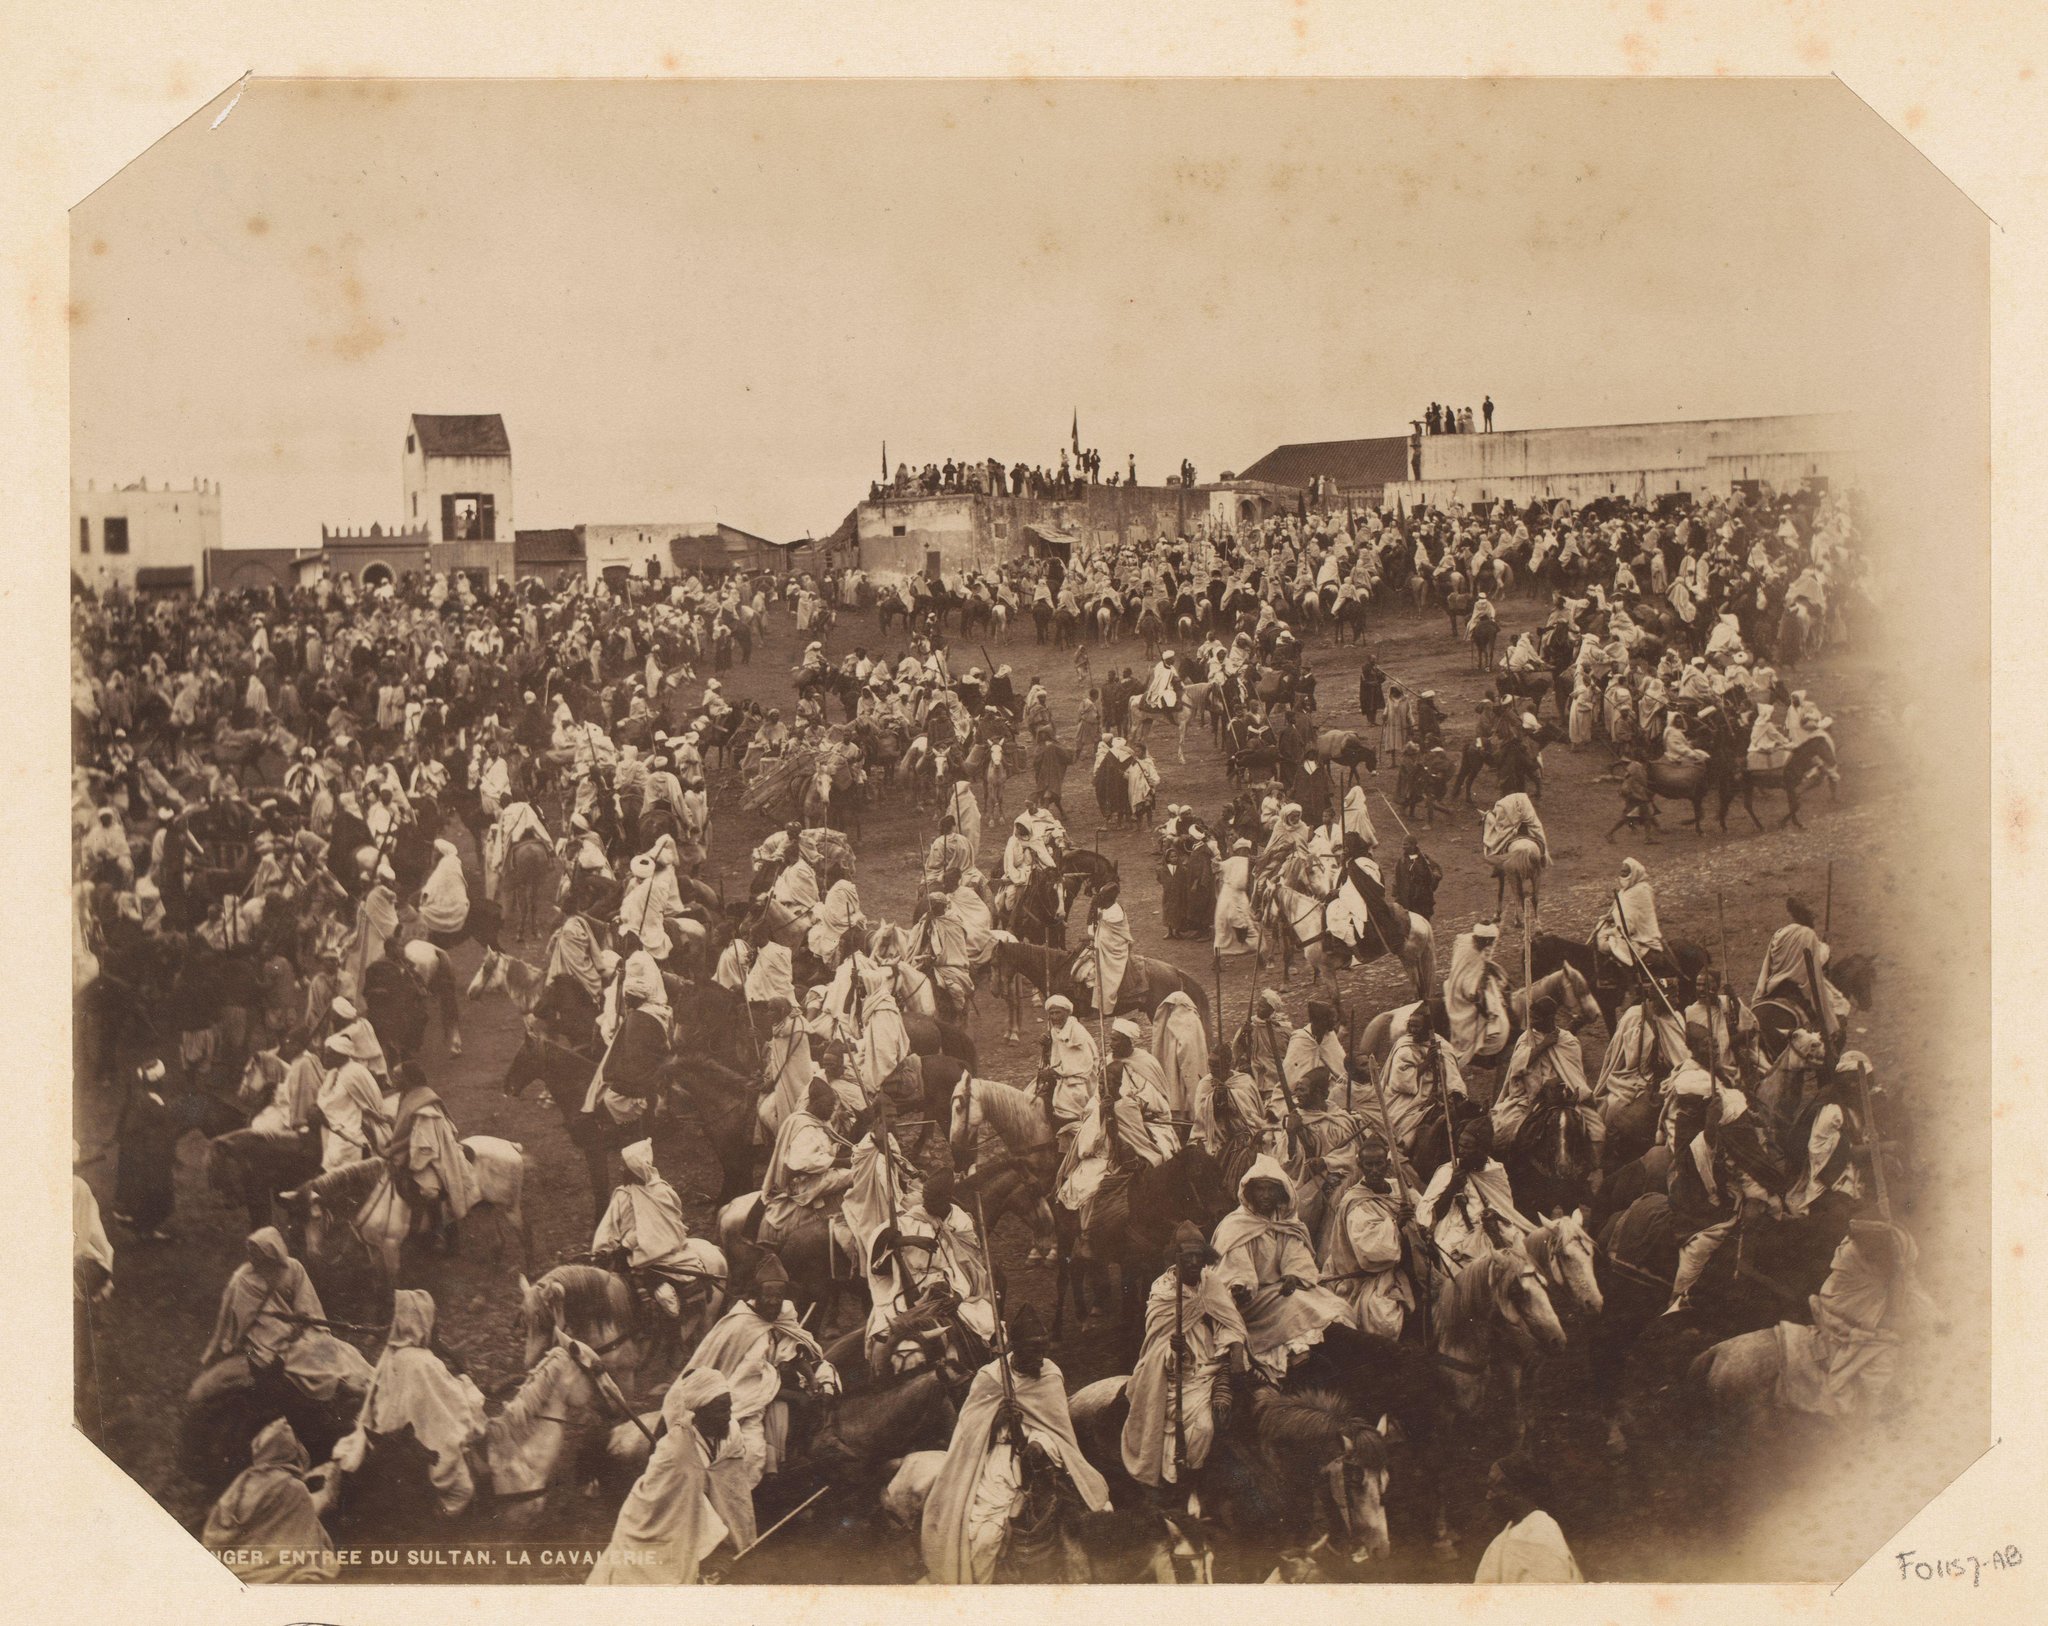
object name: photograph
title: Grote groep mannen te paard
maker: Anonymous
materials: photographic support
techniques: albumen print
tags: riding a horse, ass, or mule; rider, horseman, adult man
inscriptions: annotation: ‘Tanger (Marokko)’, number: ‘60’